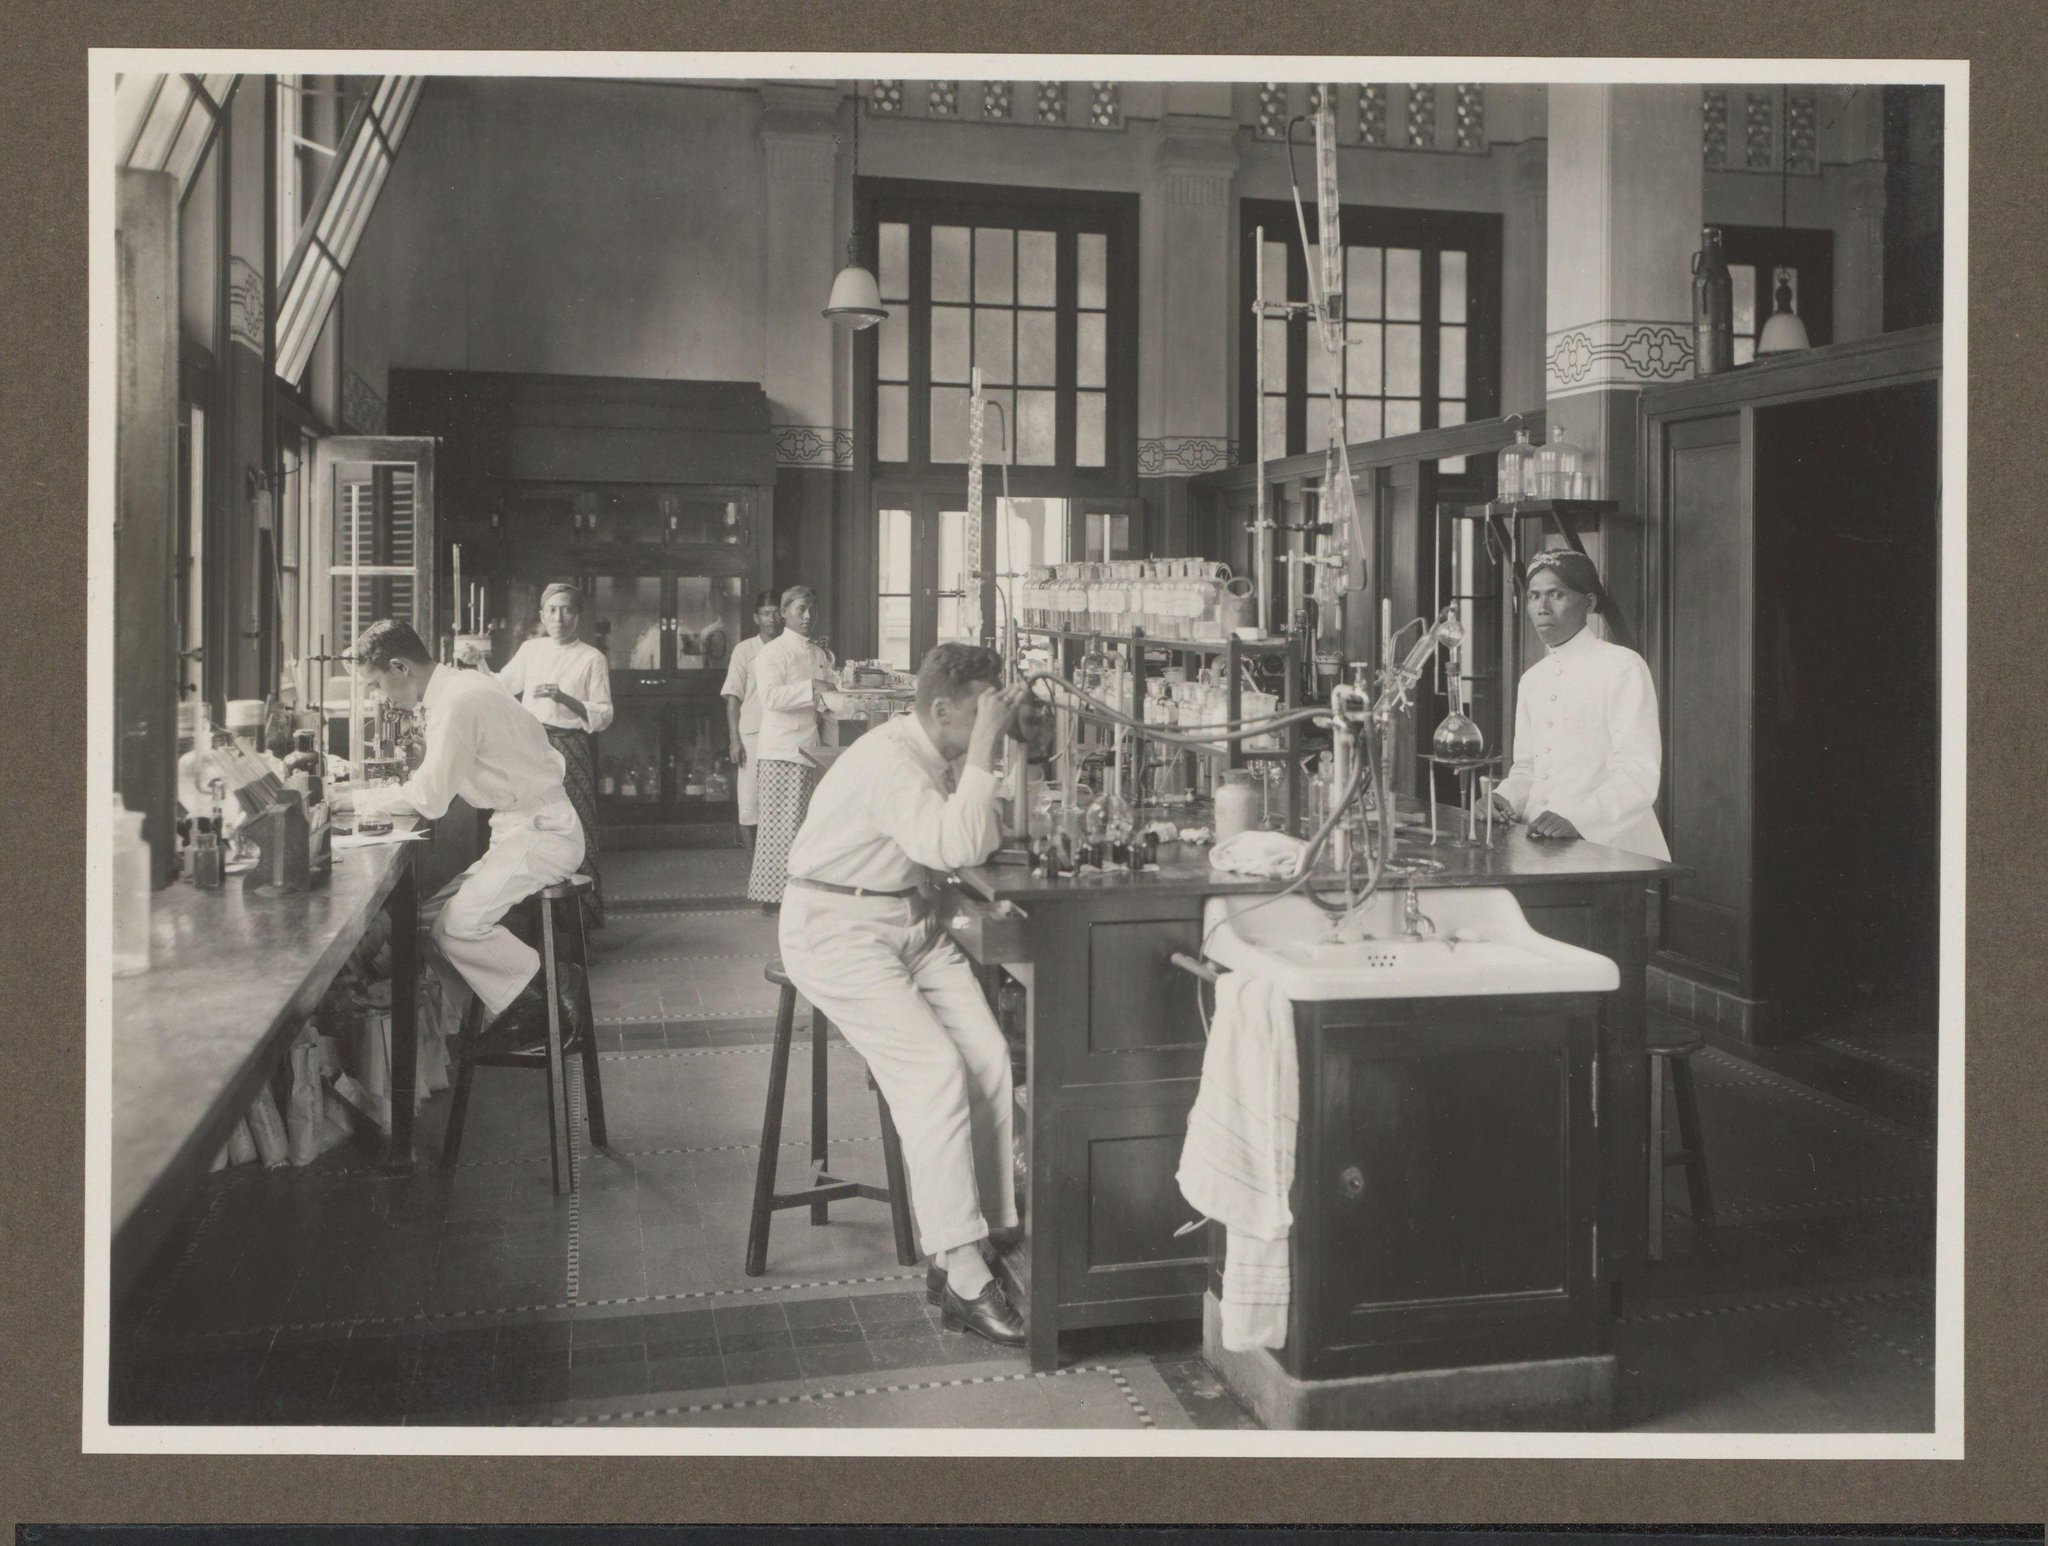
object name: photograph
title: Laboratorium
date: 1904-1931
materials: photographic support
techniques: gelatin silver print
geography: surabaya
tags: colonial system, trade-company, laboratory, research room, surabaya, java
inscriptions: inscription: ‘Laboratorium’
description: Het laboratorium, met de Europese en Javaanse werknemers bij de installaties. Foto in het het fotoalbum aangeboden aan A. van der Eyk namens de chefs en het personeel van de Handelsvereniging Amsterdam (HVA) te Soerabaja bij zijn vertrek van Java in april 1931.